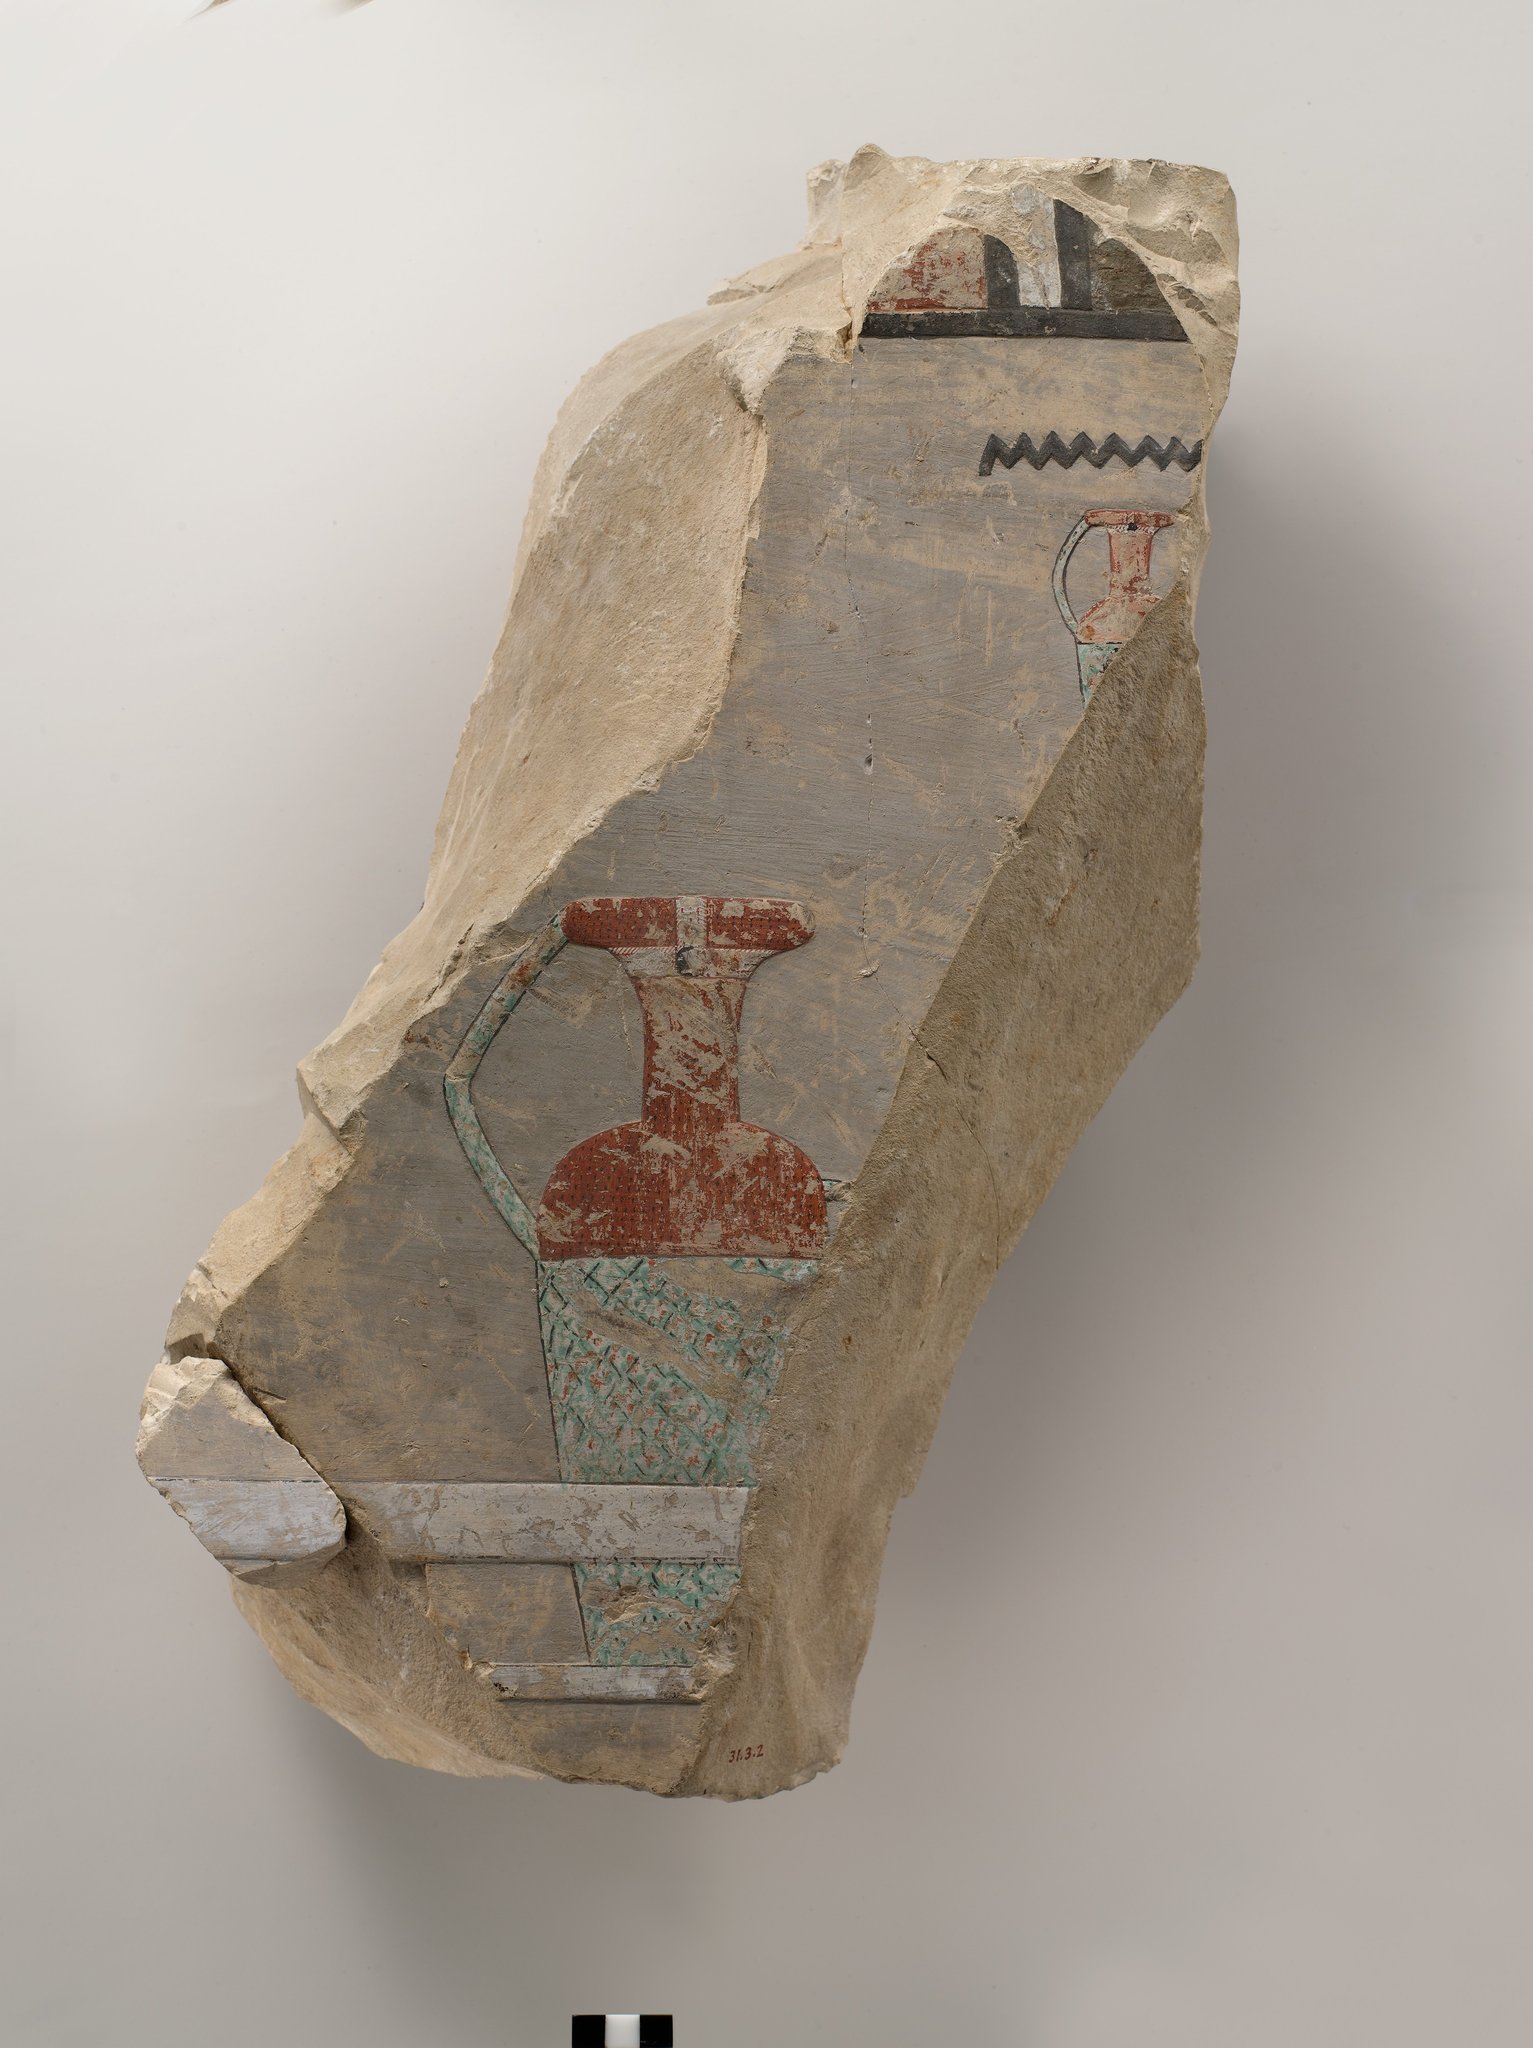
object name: relief fragment, tomb of meketre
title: Relief from the tomb of Meketre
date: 1981-1975 BCE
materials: limestone, paint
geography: egypt